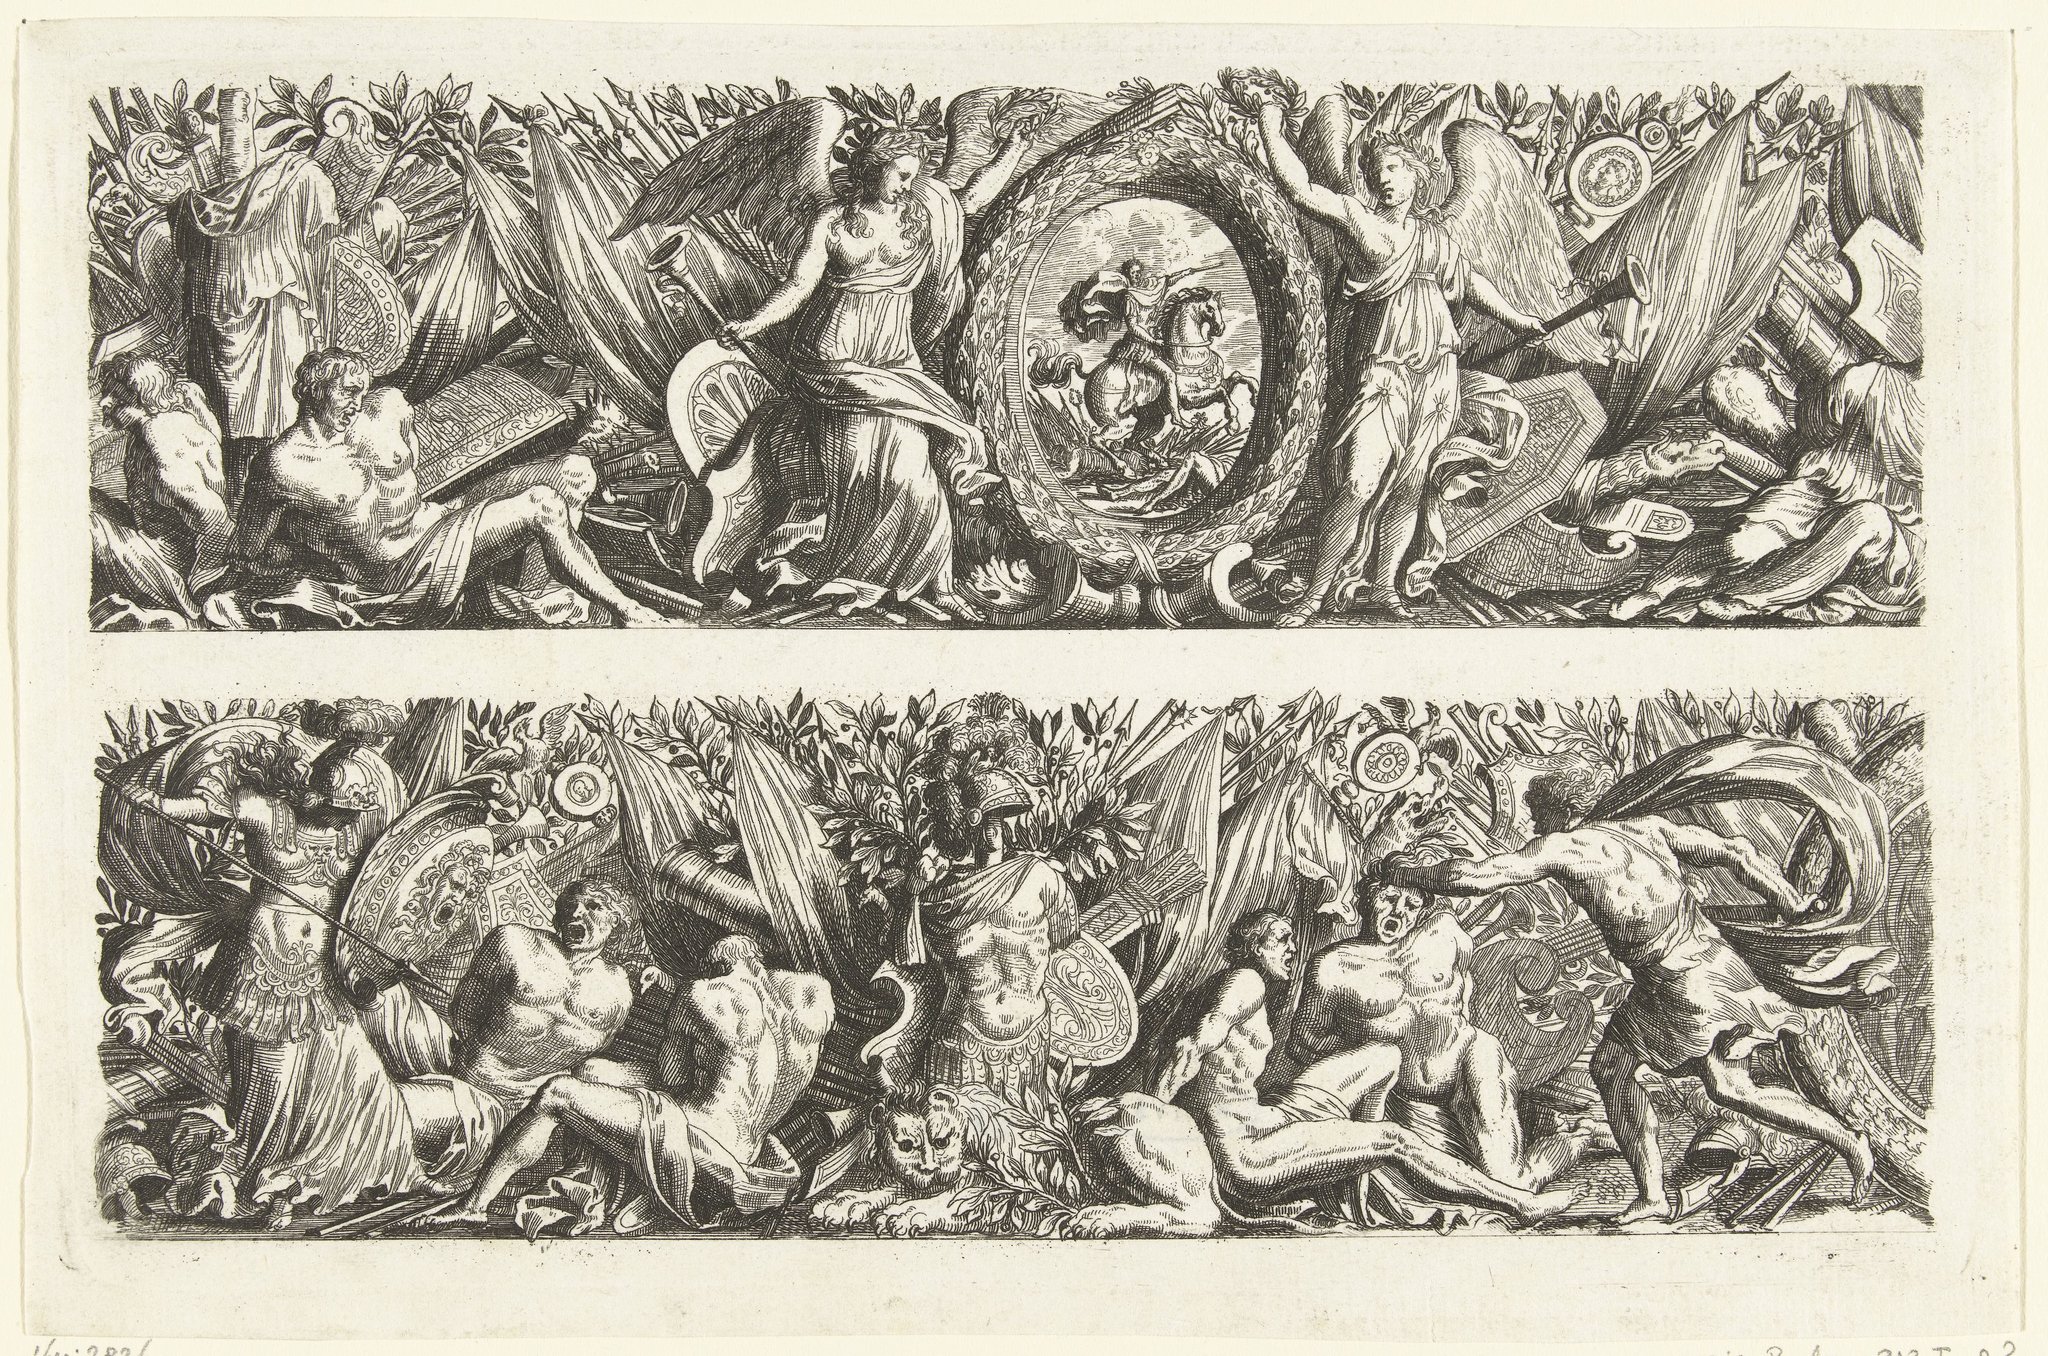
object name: ornament print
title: Twee friezen met wapentrofeëen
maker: Anonymous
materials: paper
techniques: etching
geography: netherlands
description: In het bovenste fries een ovaal medaillon met een ruiter te paard, in het onderste strijdende Romeinse soldaten.